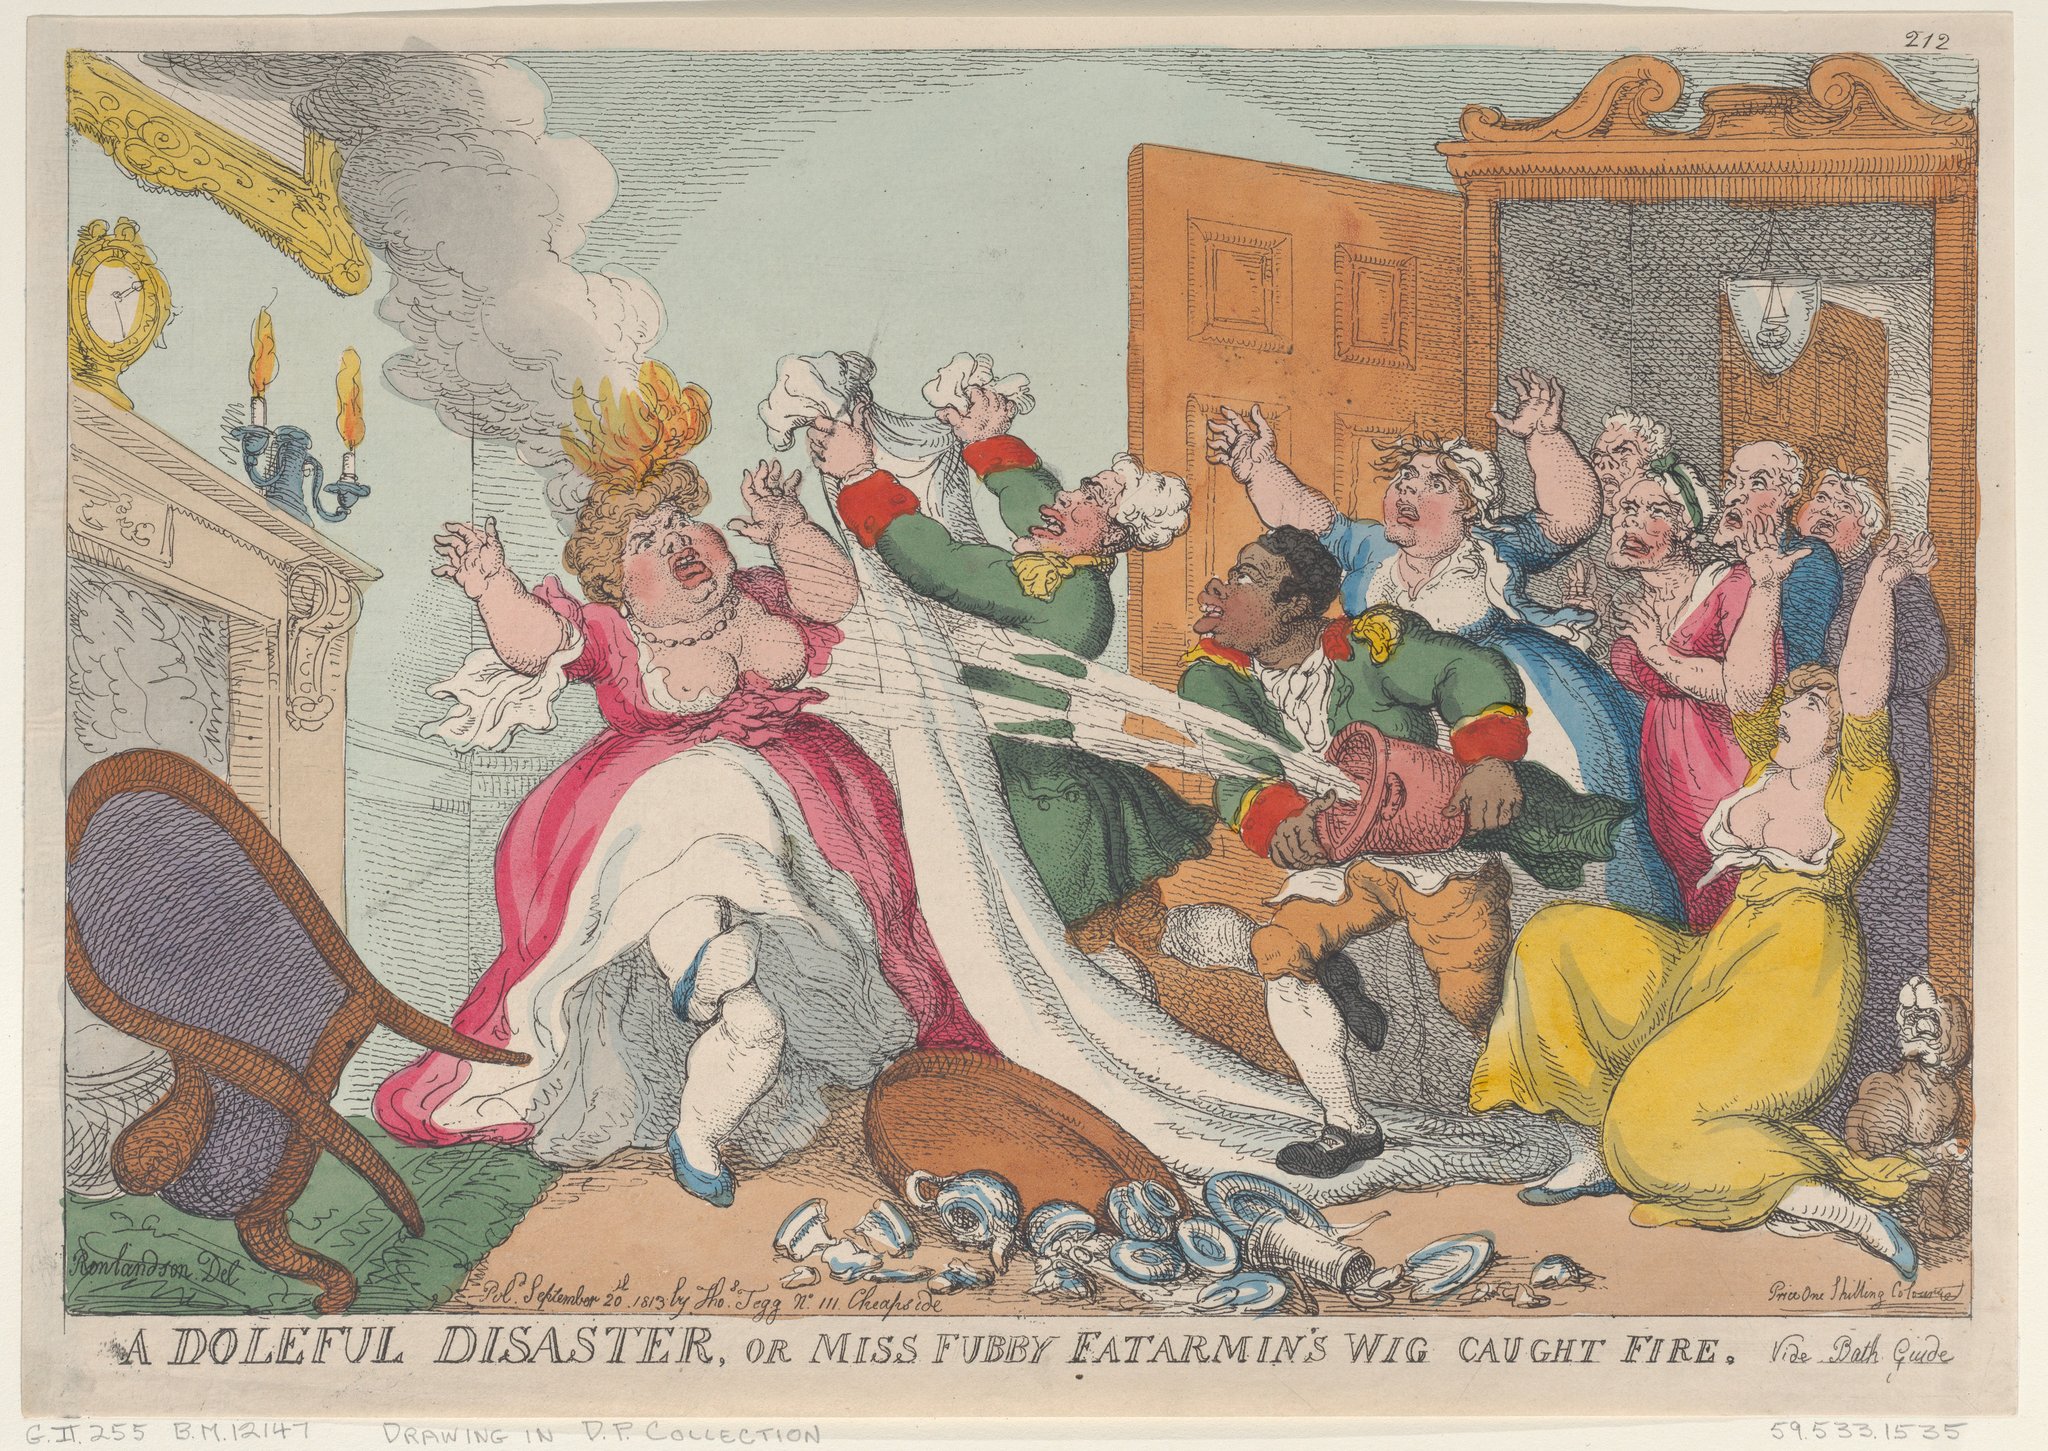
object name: print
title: A Doleful Disaster, or Miss Fubby Fatarmin's Wig Caught Fire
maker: thomas rowlandson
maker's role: artist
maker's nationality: british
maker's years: 1757-1827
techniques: etching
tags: satire,men,women,fire